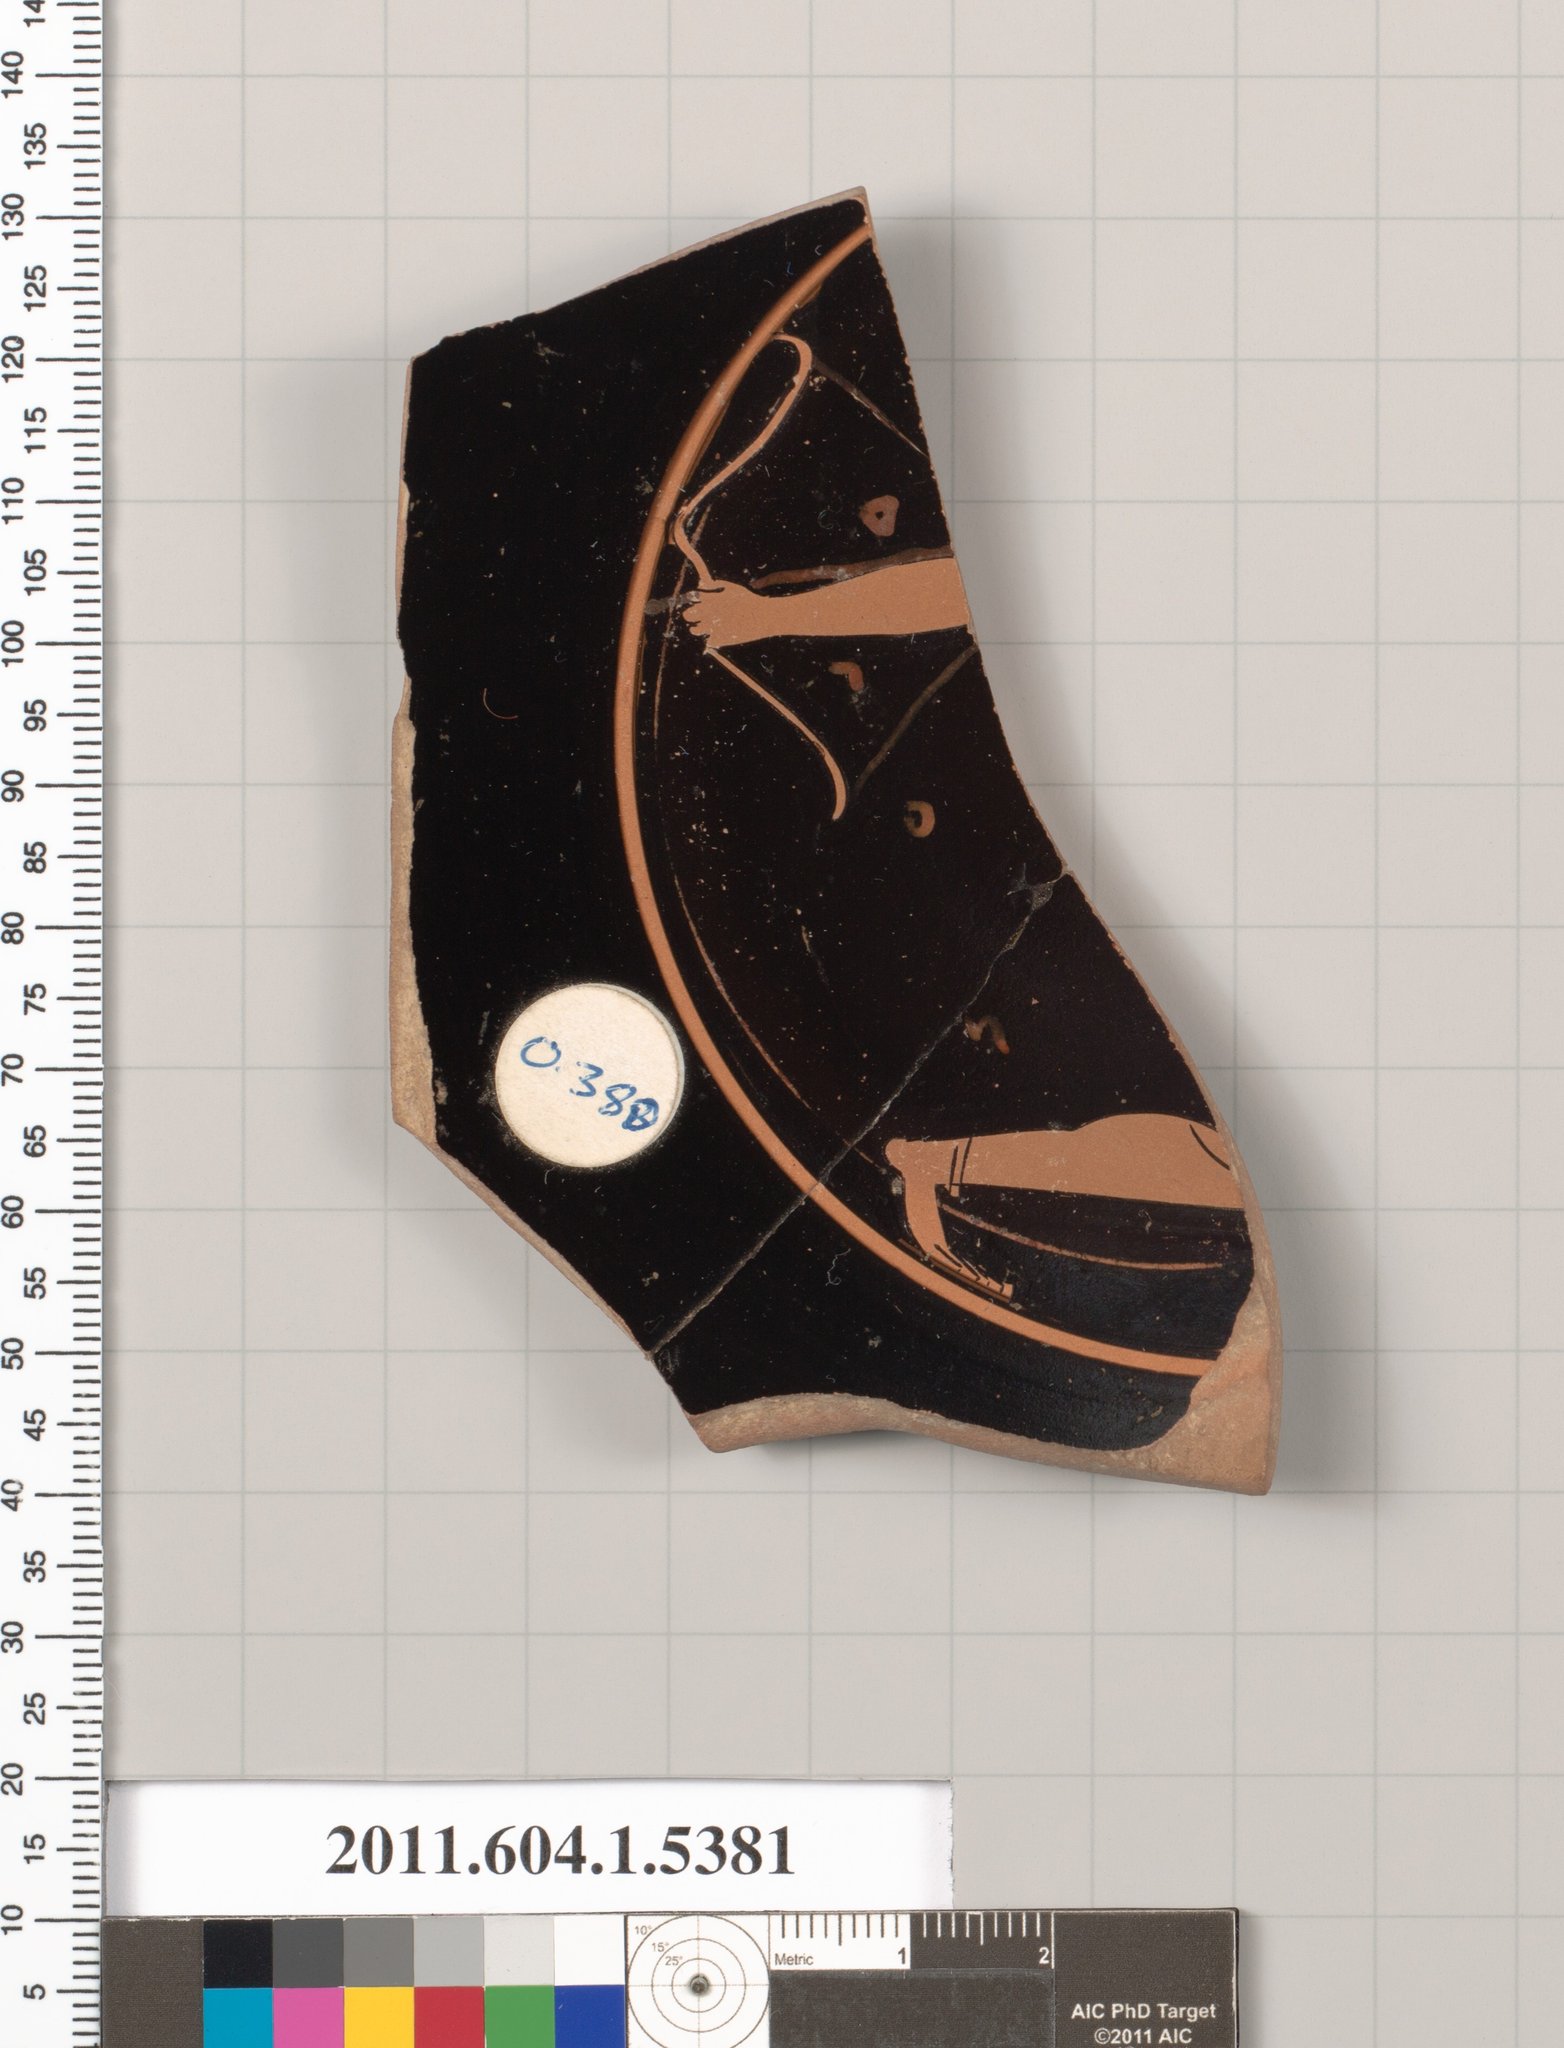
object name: kylix fragment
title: Terracotta fragment of a kylix (drinking cup)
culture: greek, attic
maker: colmar painter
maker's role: artist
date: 500-490 BCE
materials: terracotta